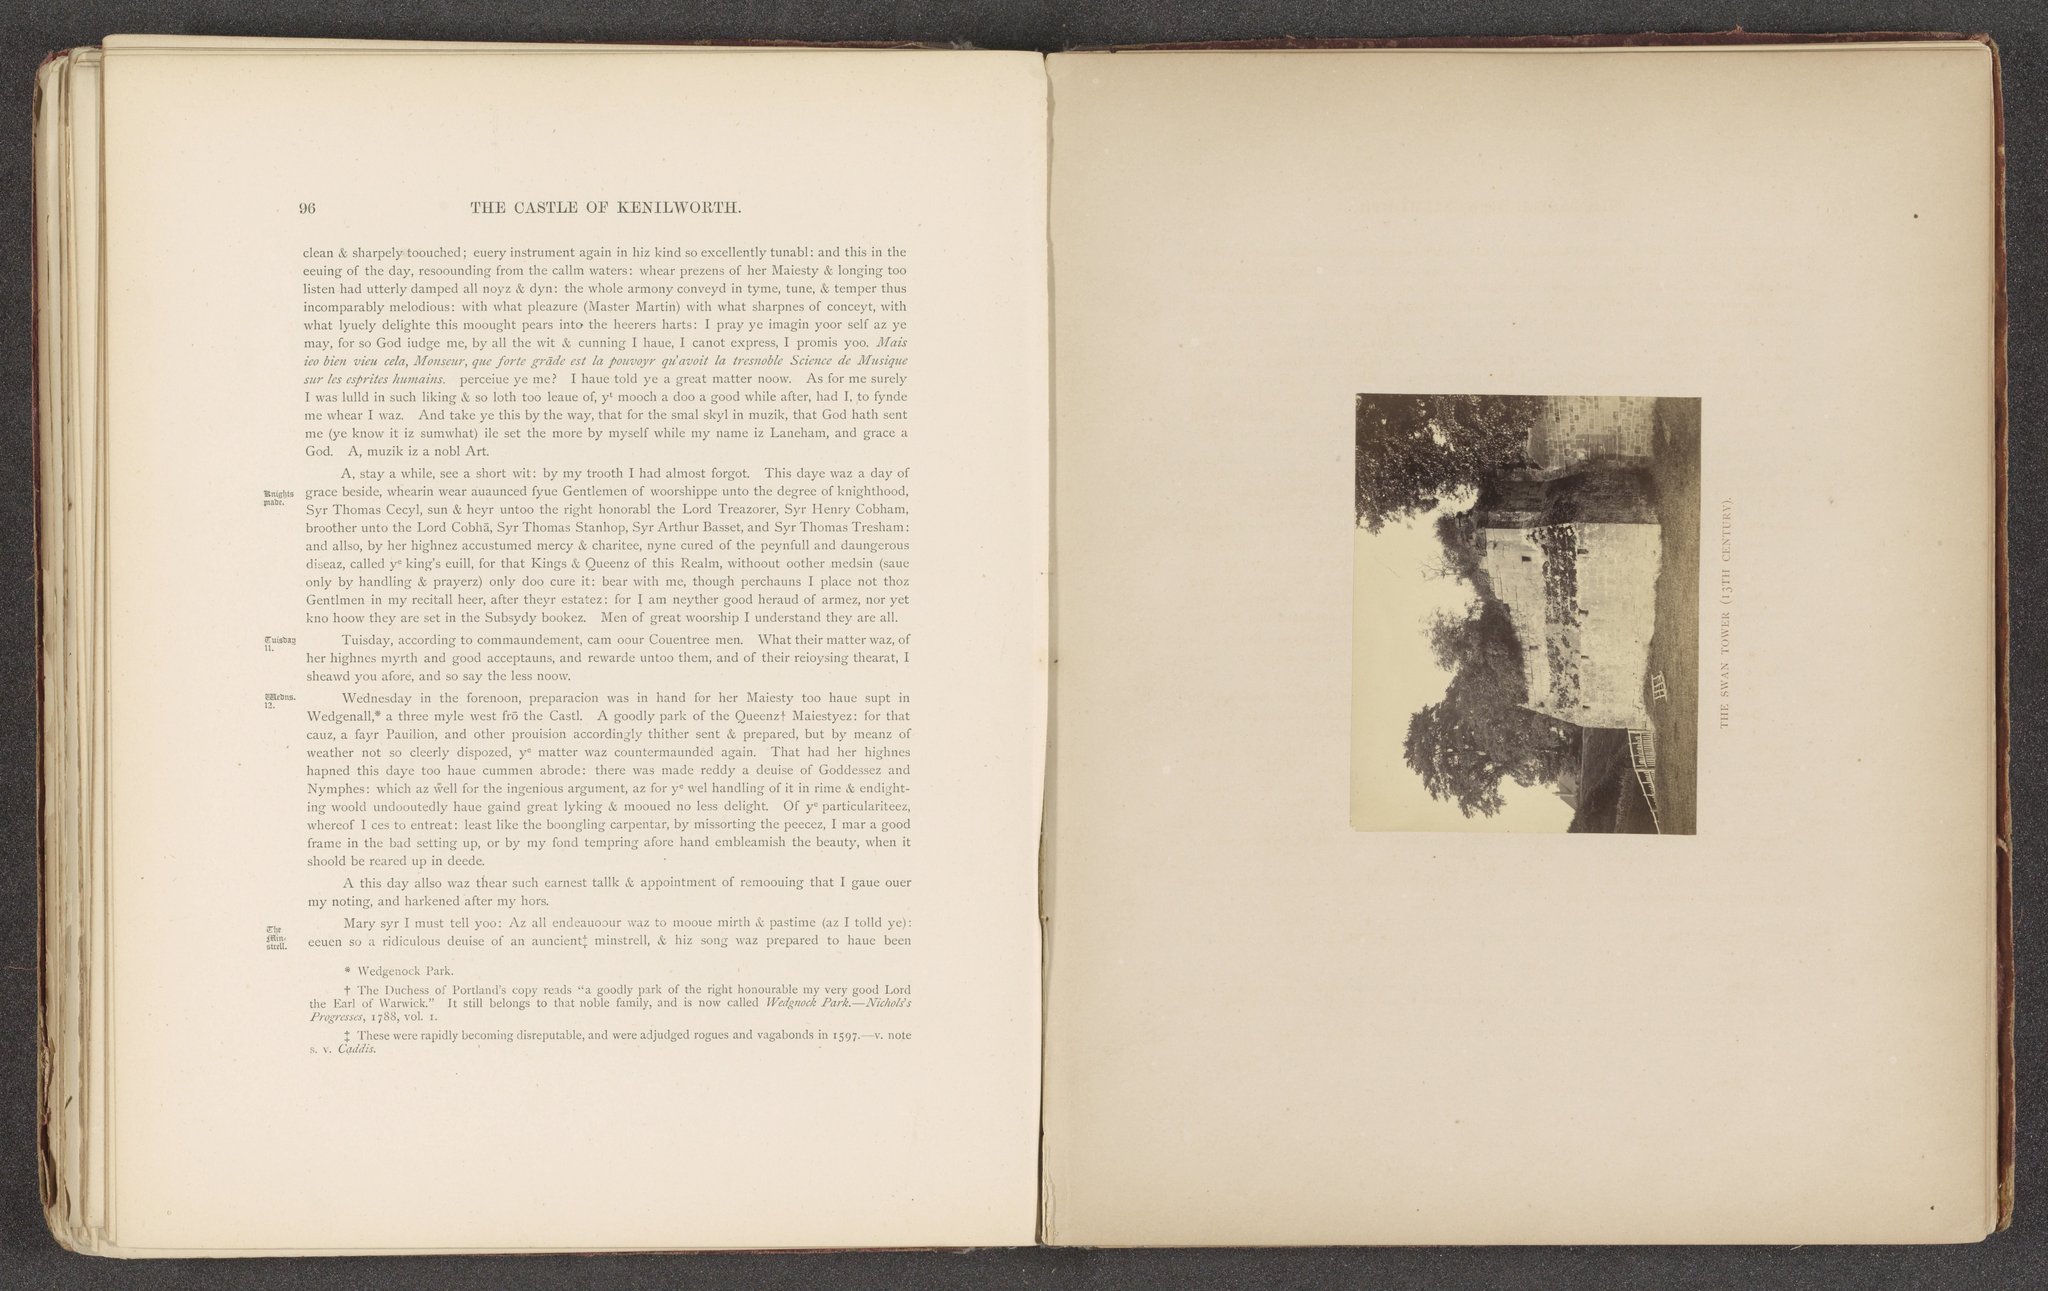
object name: photograph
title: The Swan Tower (13th Century)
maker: Anonymous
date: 1862-1872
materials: photographic support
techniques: albumen print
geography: kenilworth castle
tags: tower, clock tower ~ monumental adornment, ruin of a dwelling, house, castle, etc.